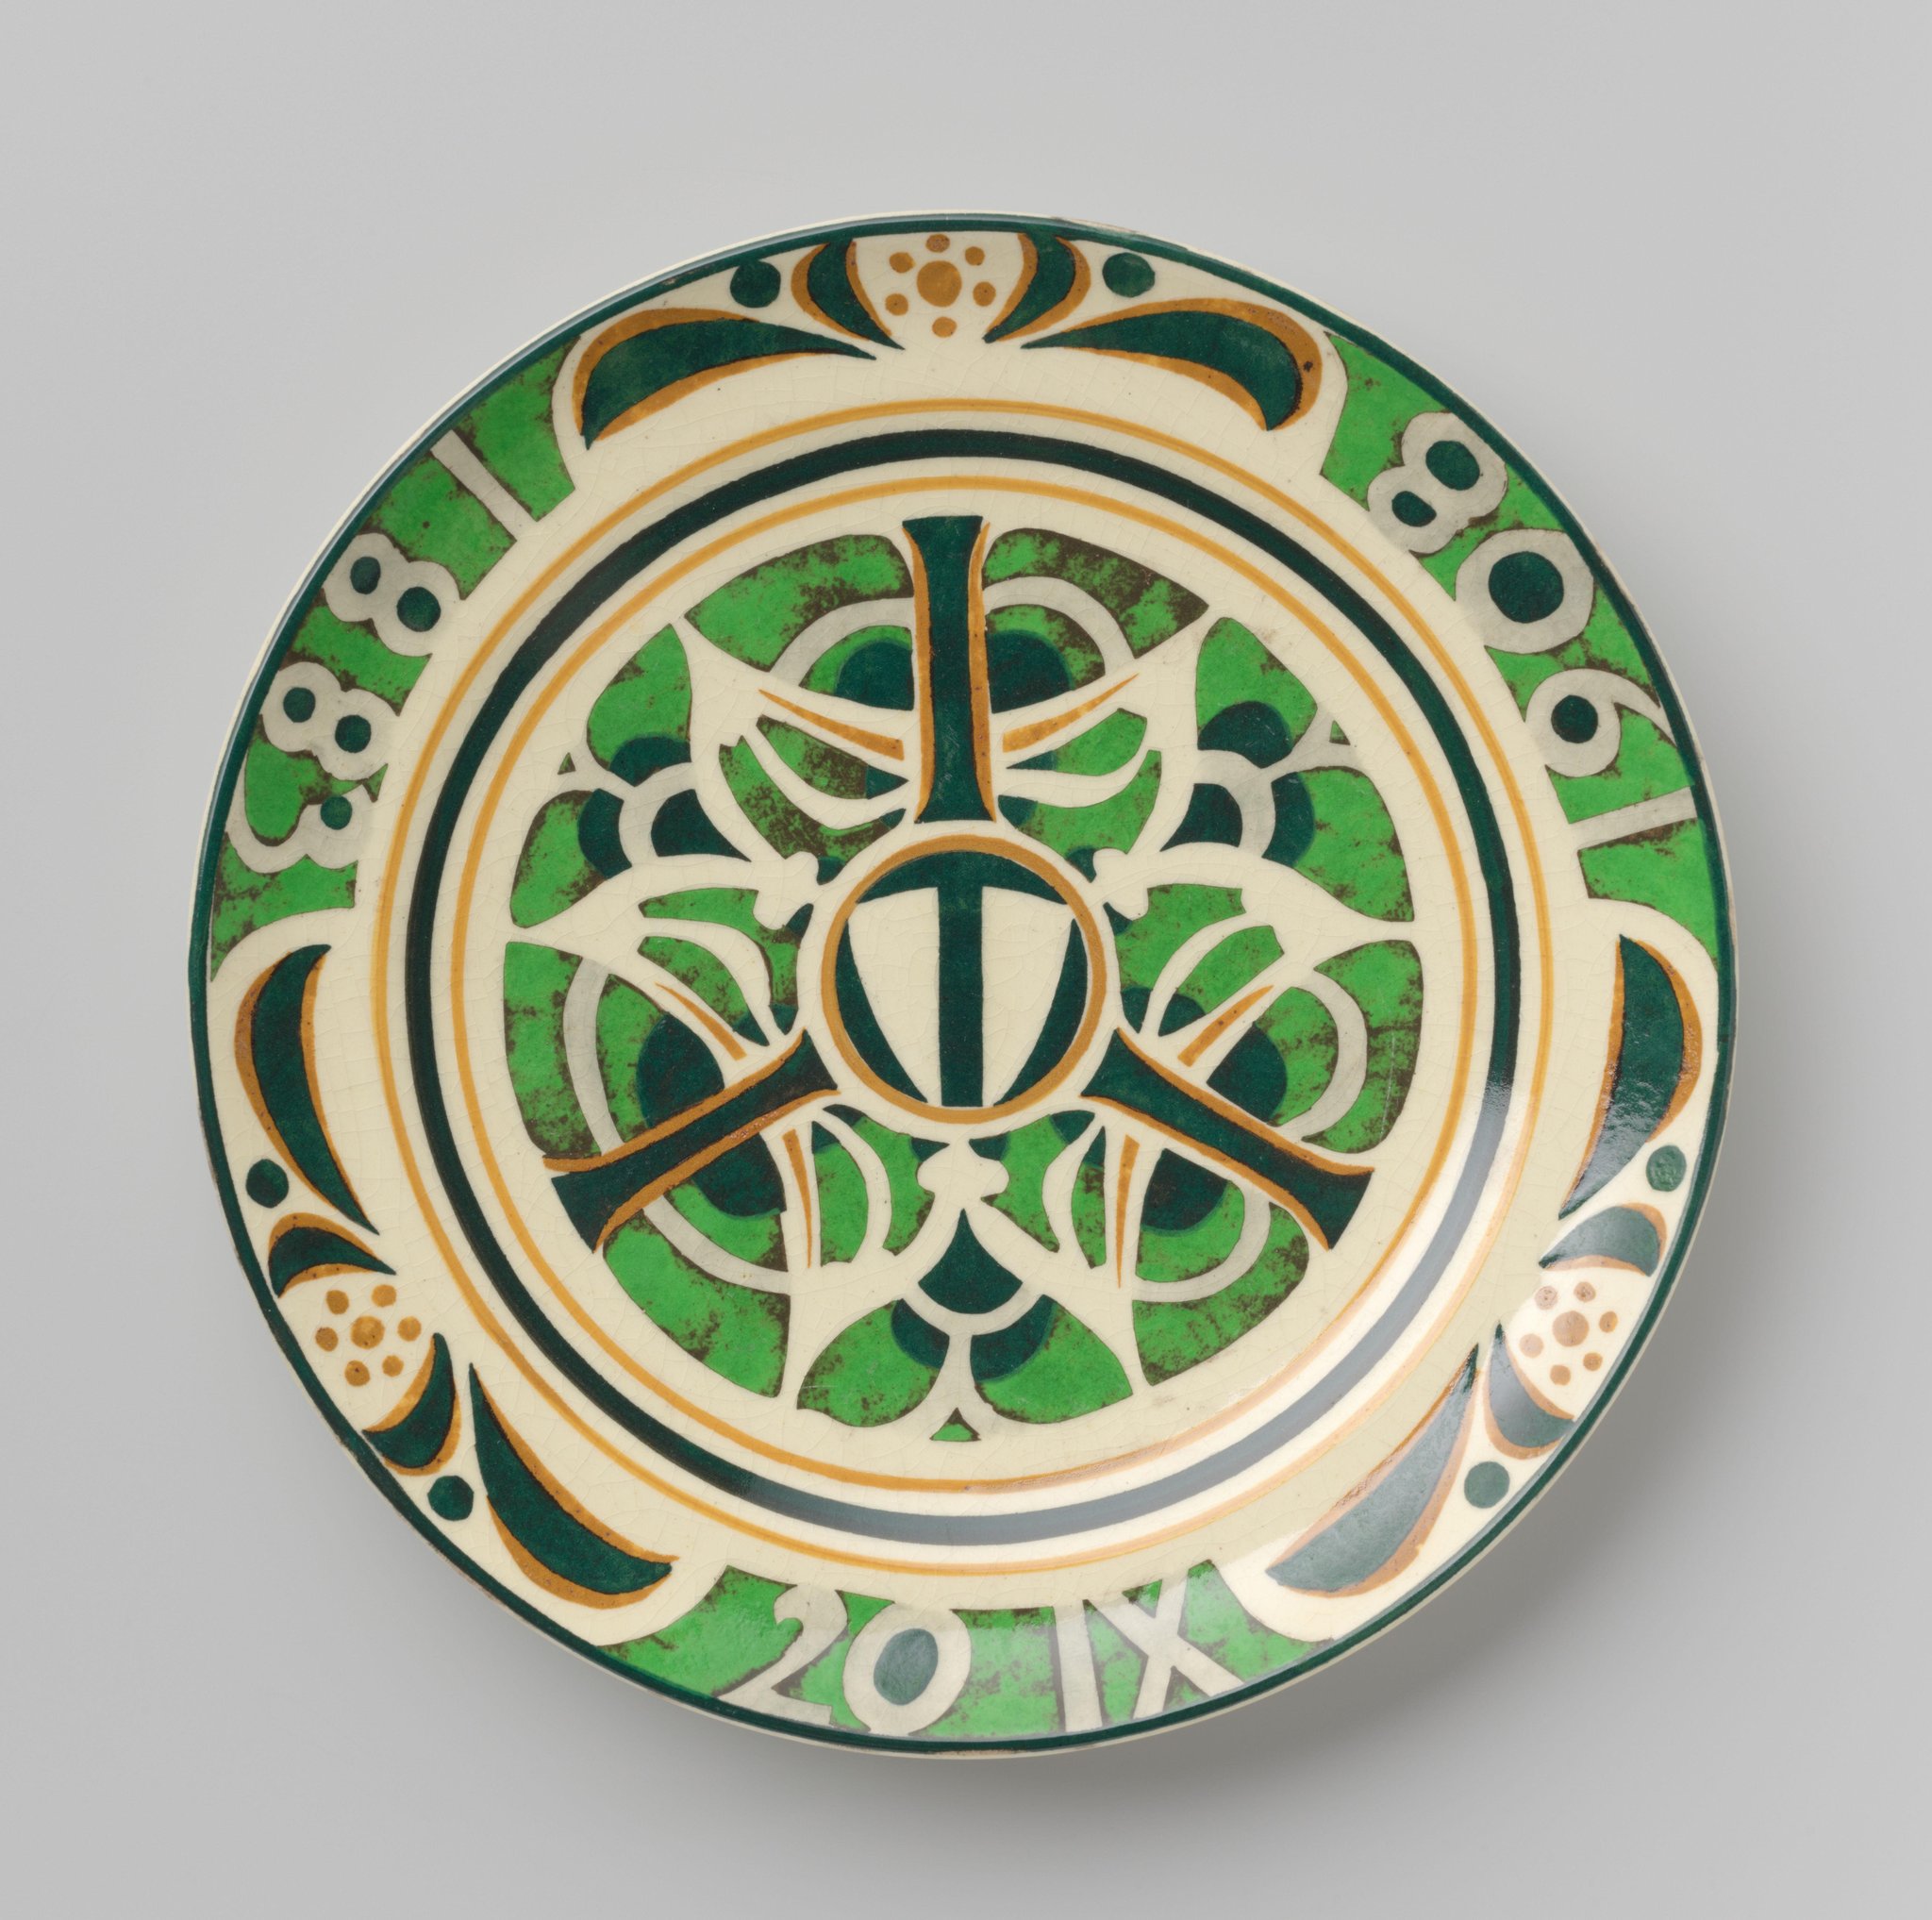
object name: plate dish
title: Wandbord t.g.v. de 25-jarige bruiloft van J.R. Tutein Nolthenius en M.A. Cordes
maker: carel adolph lion cachet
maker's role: draughtsman, print maker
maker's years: 1864-1945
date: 1908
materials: earthenware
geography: delft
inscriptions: inscription: ‘20 IX / 1883 / 1908’, mark: ‘cirkelvormig fabrieksstempel met de naam en WZ in het midden, 28 daarbuiten en H in de cirkel.’, inscription: ‘ZILVEREN BRUILOFT// J.T. TUTEIN NOLTHENIUS // M.A. CORDES. // aangeboden door: // J.E.Crommelin T.N. // en Jacques T.N.’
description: Wandbord van aardewerk, t.g.v. de 25-jarige bruiloft van J.R. Tutein Nolthenius en M.A. Cordes. OP de rand staat 20 IX / 1883 / 1908. Het decor is in groen, geelbruin en zwart op lichtgele fond. In het midden een wapenschild binnen een cirkel. Op de achterkant in zwart ZILVEREN BRUILOFT J.T. TUTEIN NOLTHENIUS M.A. CORDES. aangeboden door: J.E. rommelen T.N. en Jacques T.N.. Twee ophanggaten in de voetring.